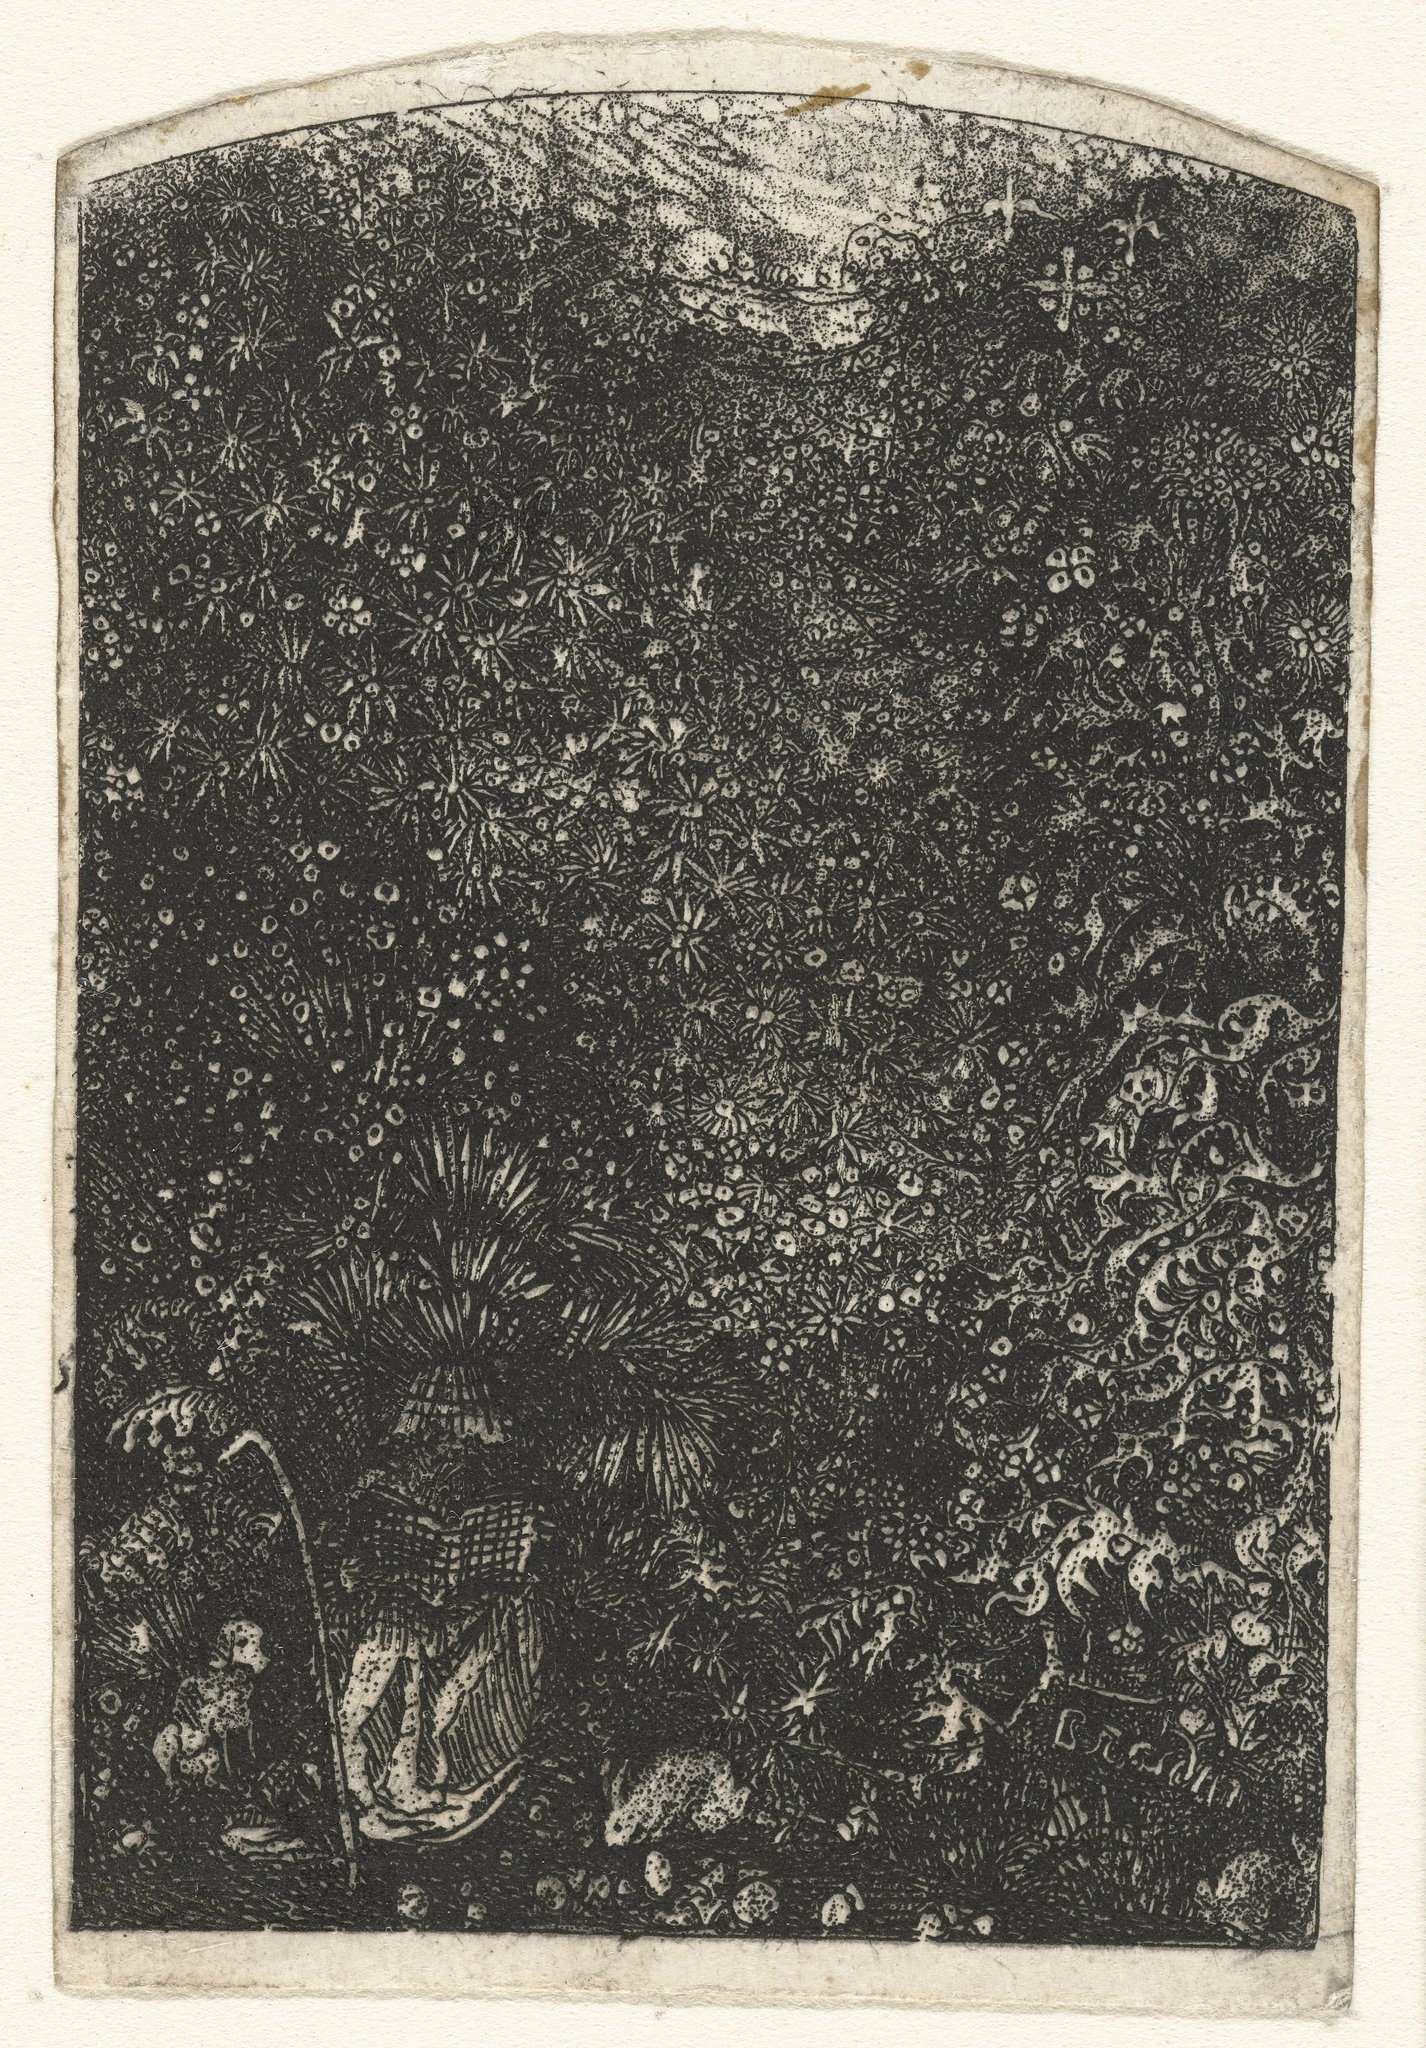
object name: print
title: Heilige Hieronymus in landschap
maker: rodolphe bresdin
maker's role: draughtsman, print maker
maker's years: 1822-1885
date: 1860-1861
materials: paper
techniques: etching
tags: the monk and hermit jerome (hieronymus); possible attributes: book, cardinal's hat, crucifix, hour-glass, lion, skull, stone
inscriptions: collector's mark: Lugt 2228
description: Heilige Hieronymus zit te lezen in een boek in een landschap. Links zit een hond en rechts een wit konijn. De kleine figuur van de heilige is nauwelijks te onderscheiden van de achtergrond met het dichte struikgewas.